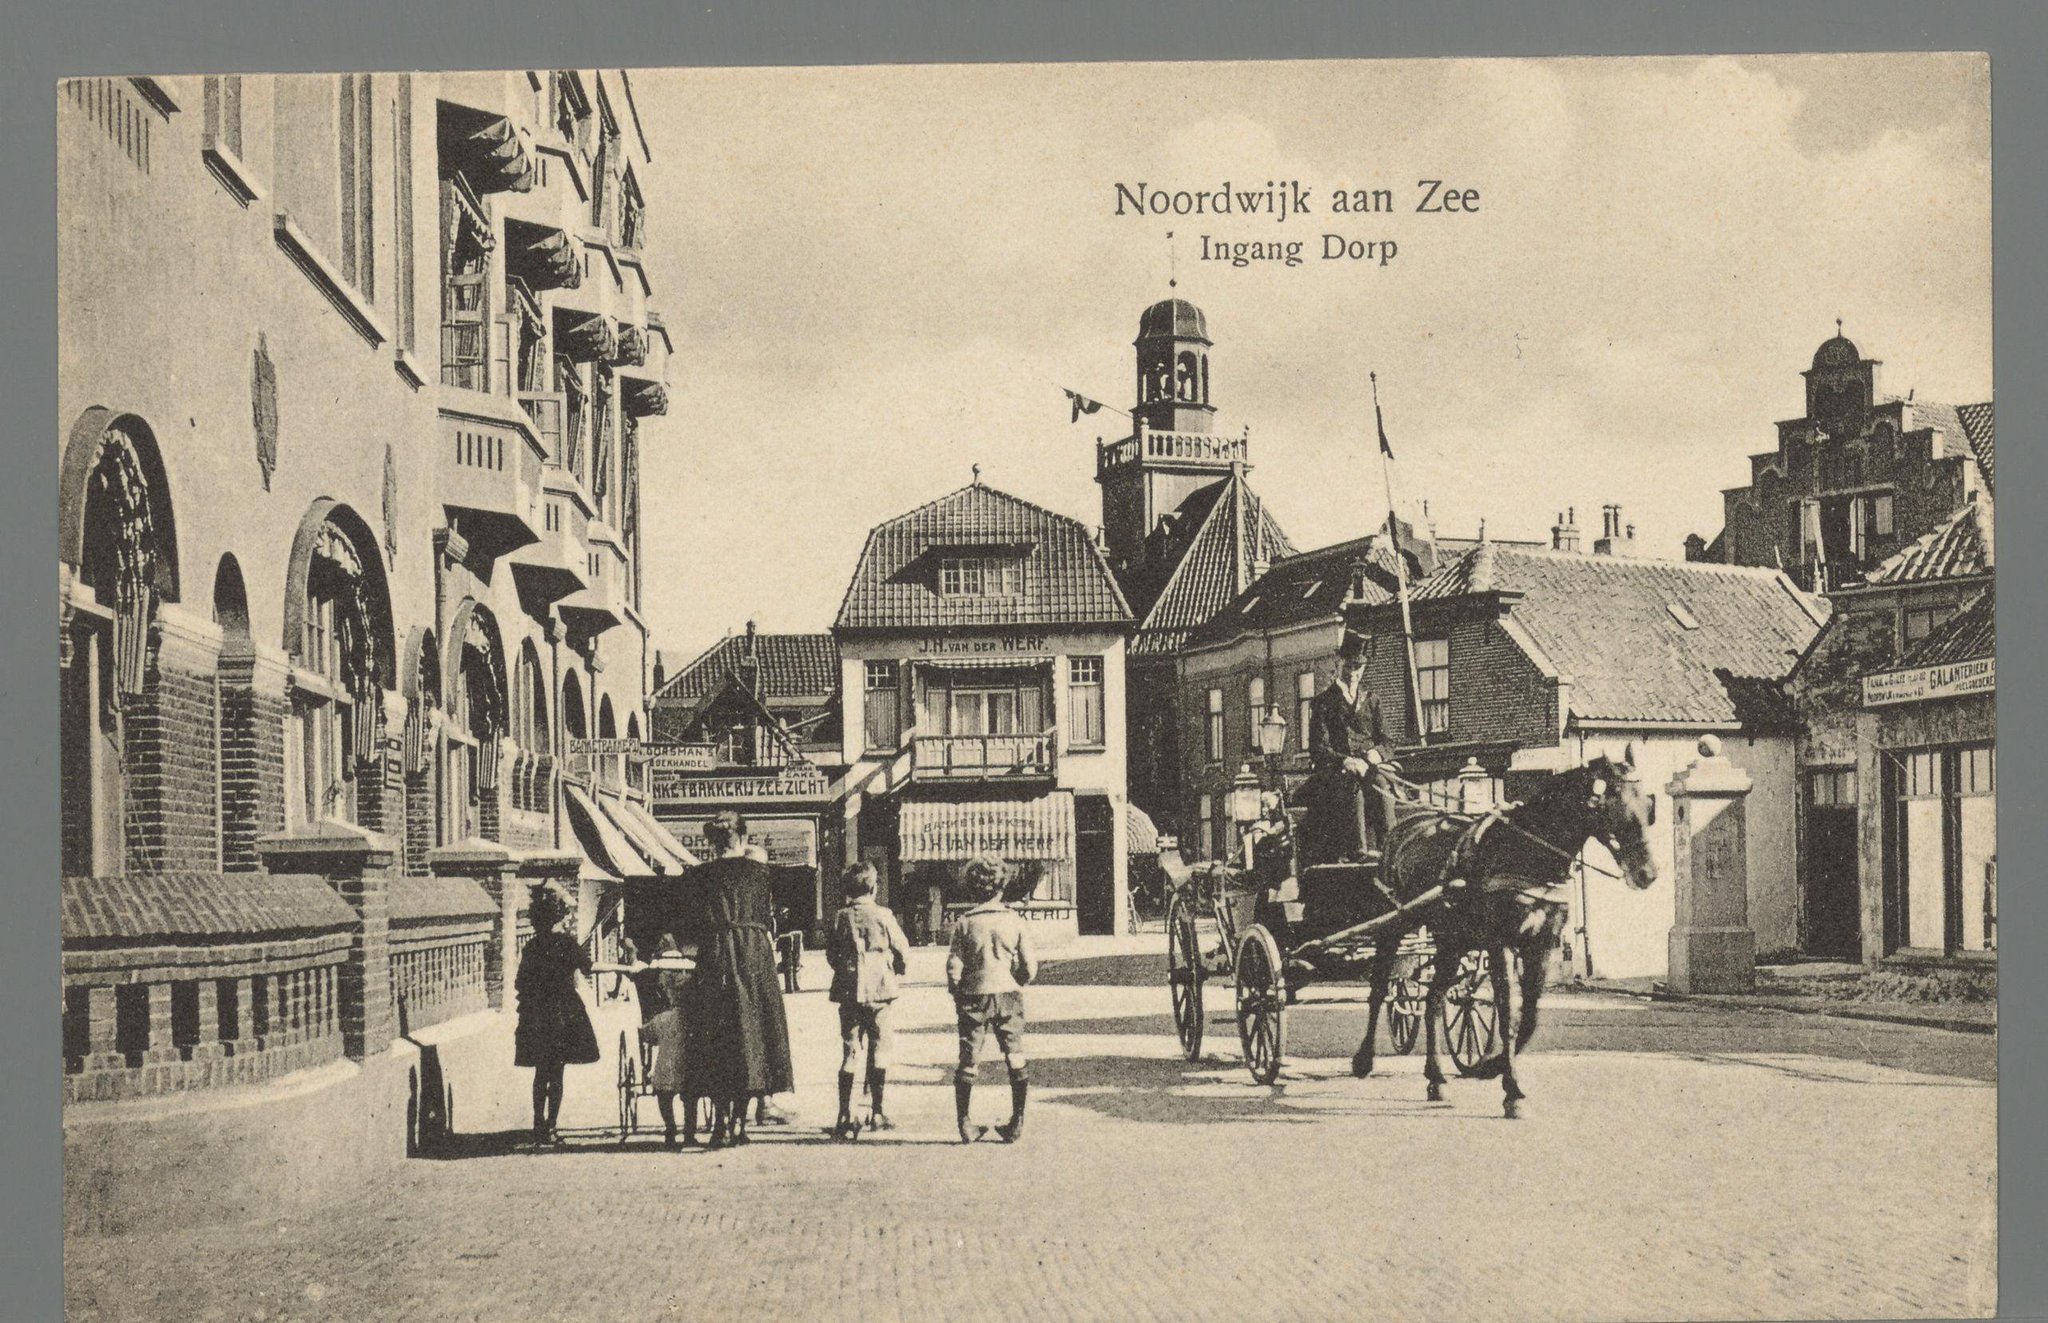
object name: ansichtkaart, prentbriefkaart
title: Noordwijk aan Zee. Ingang dorp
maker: Anonymous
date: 1924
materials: cardboard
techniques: photograph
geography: noordwijk aan zee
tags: village street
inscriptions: date